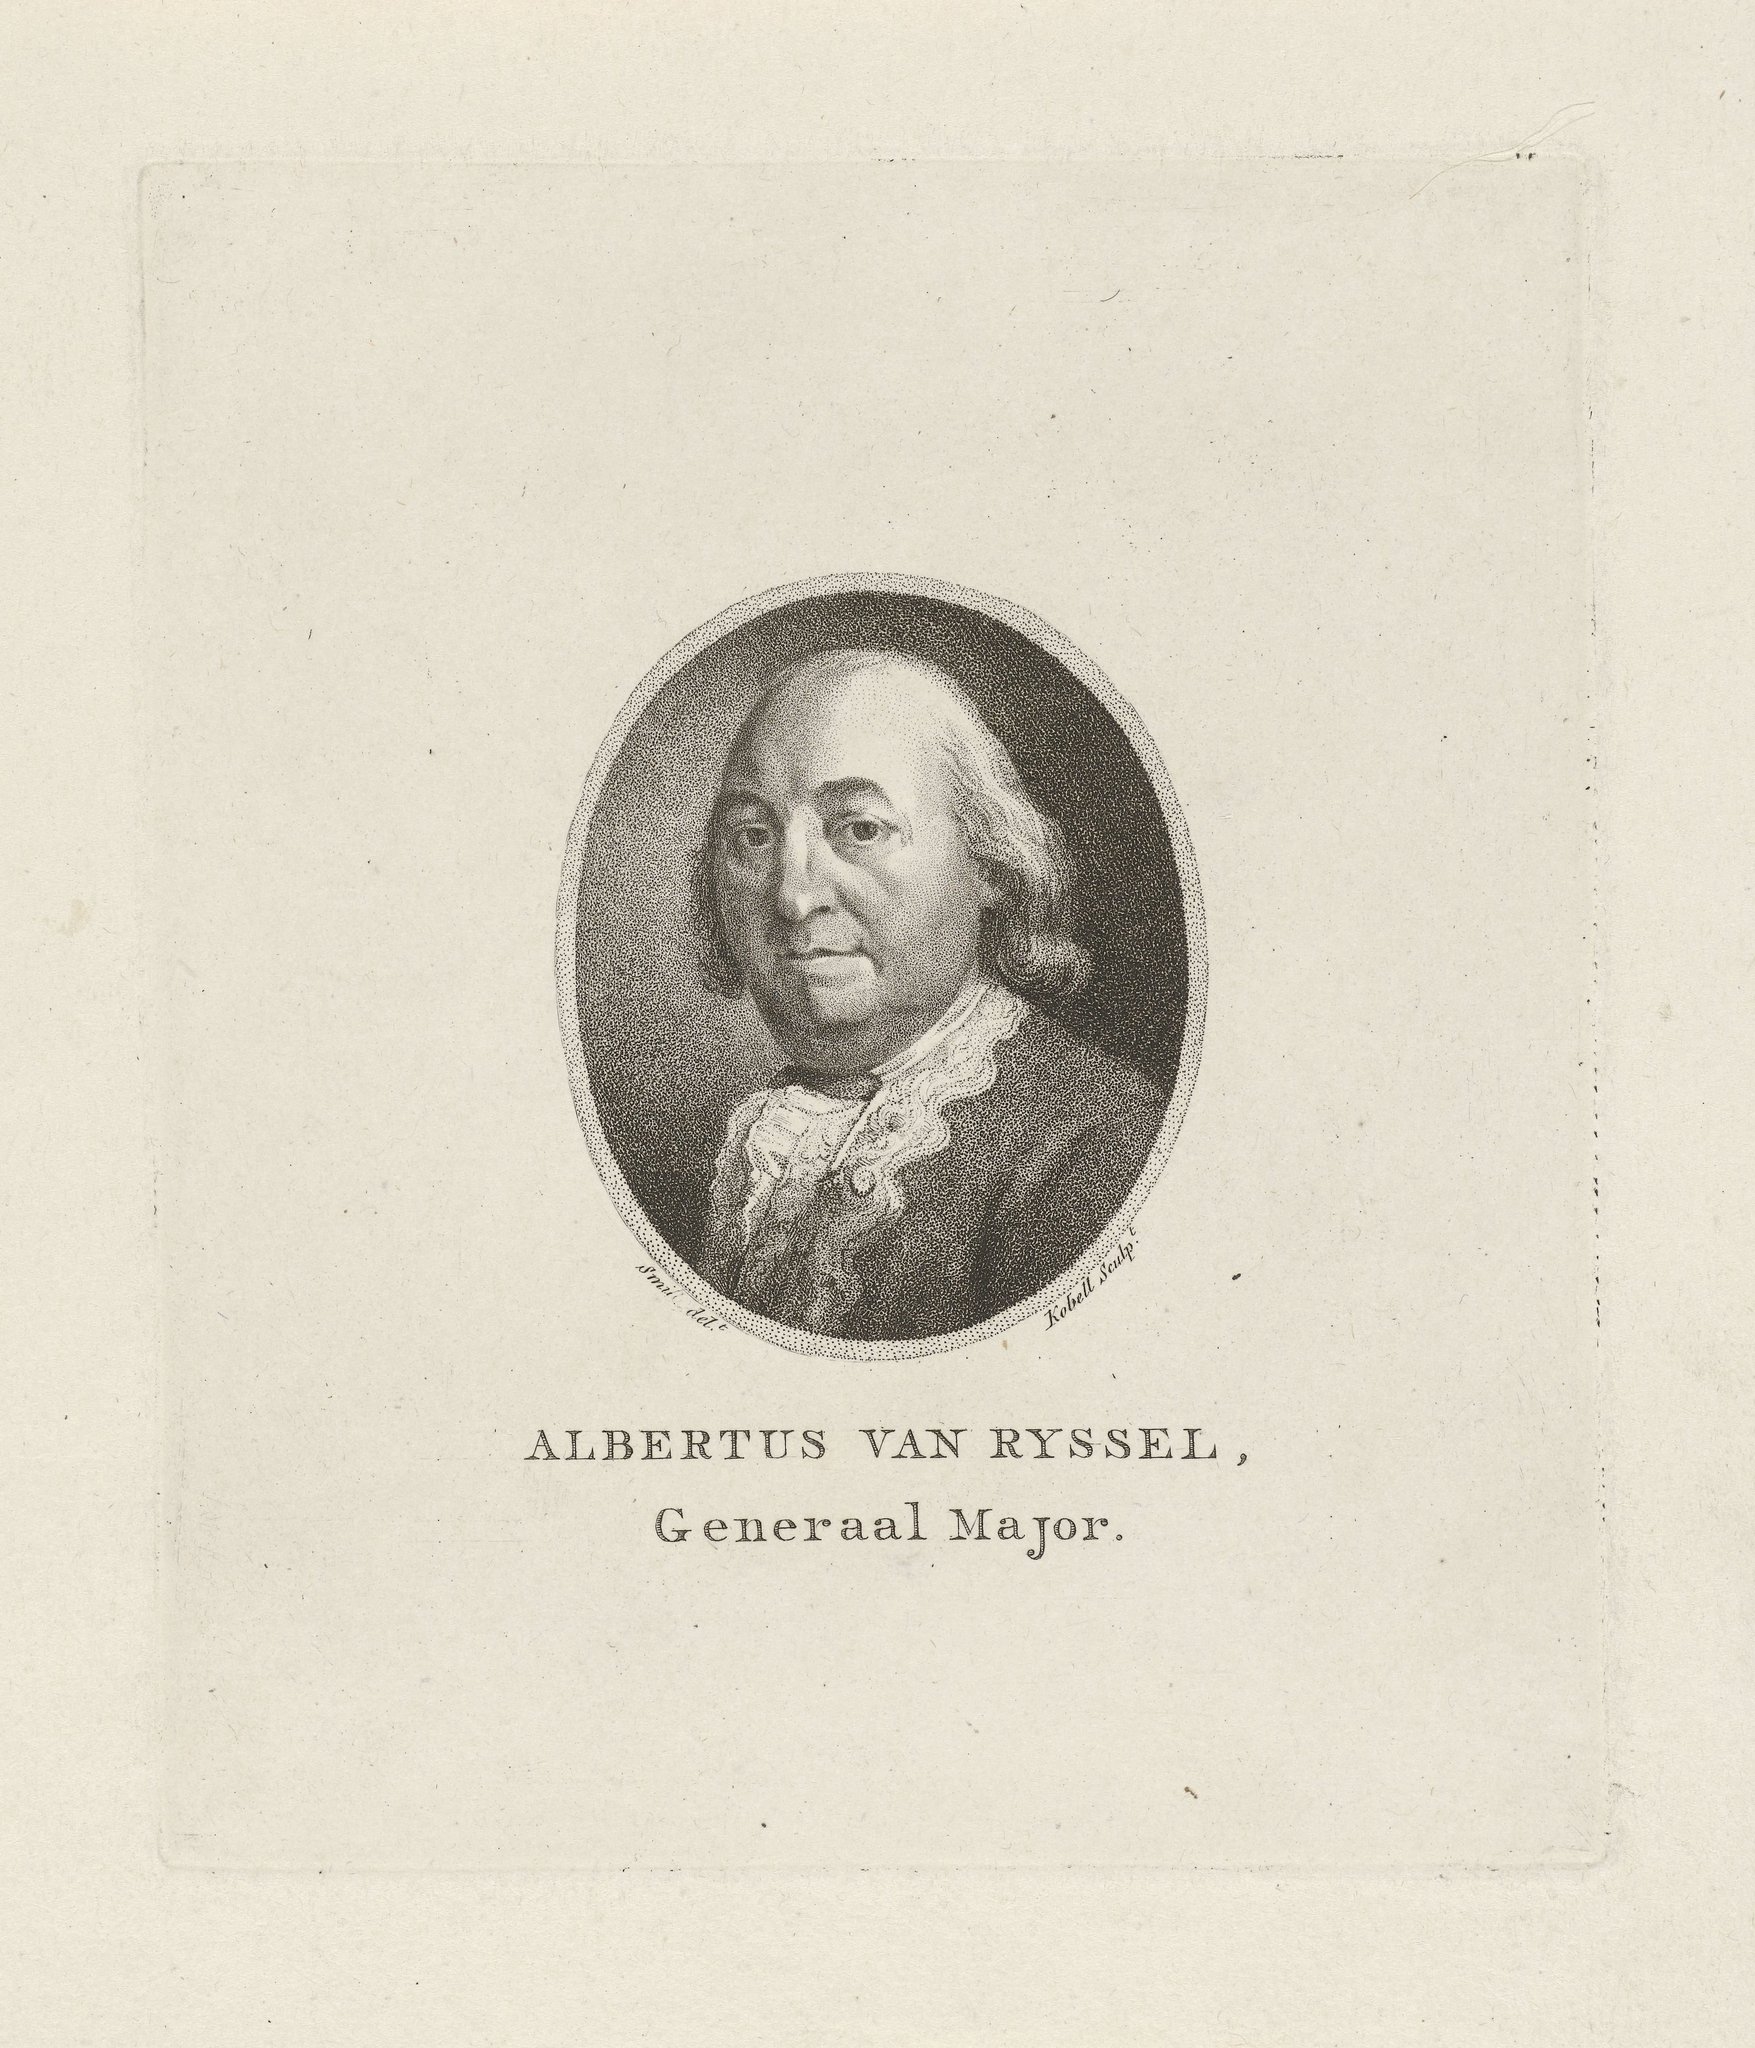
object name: print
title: Portret van Albert van Ryssel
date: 1787-1833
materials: paper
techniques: etching, engraving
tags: generaal-majoor, albert van ryssel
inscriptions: collector's mark: Lugt 2228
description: Portretbuste in ovaal naar links van Albert van Ryssel, generaal-majoor in 1787.